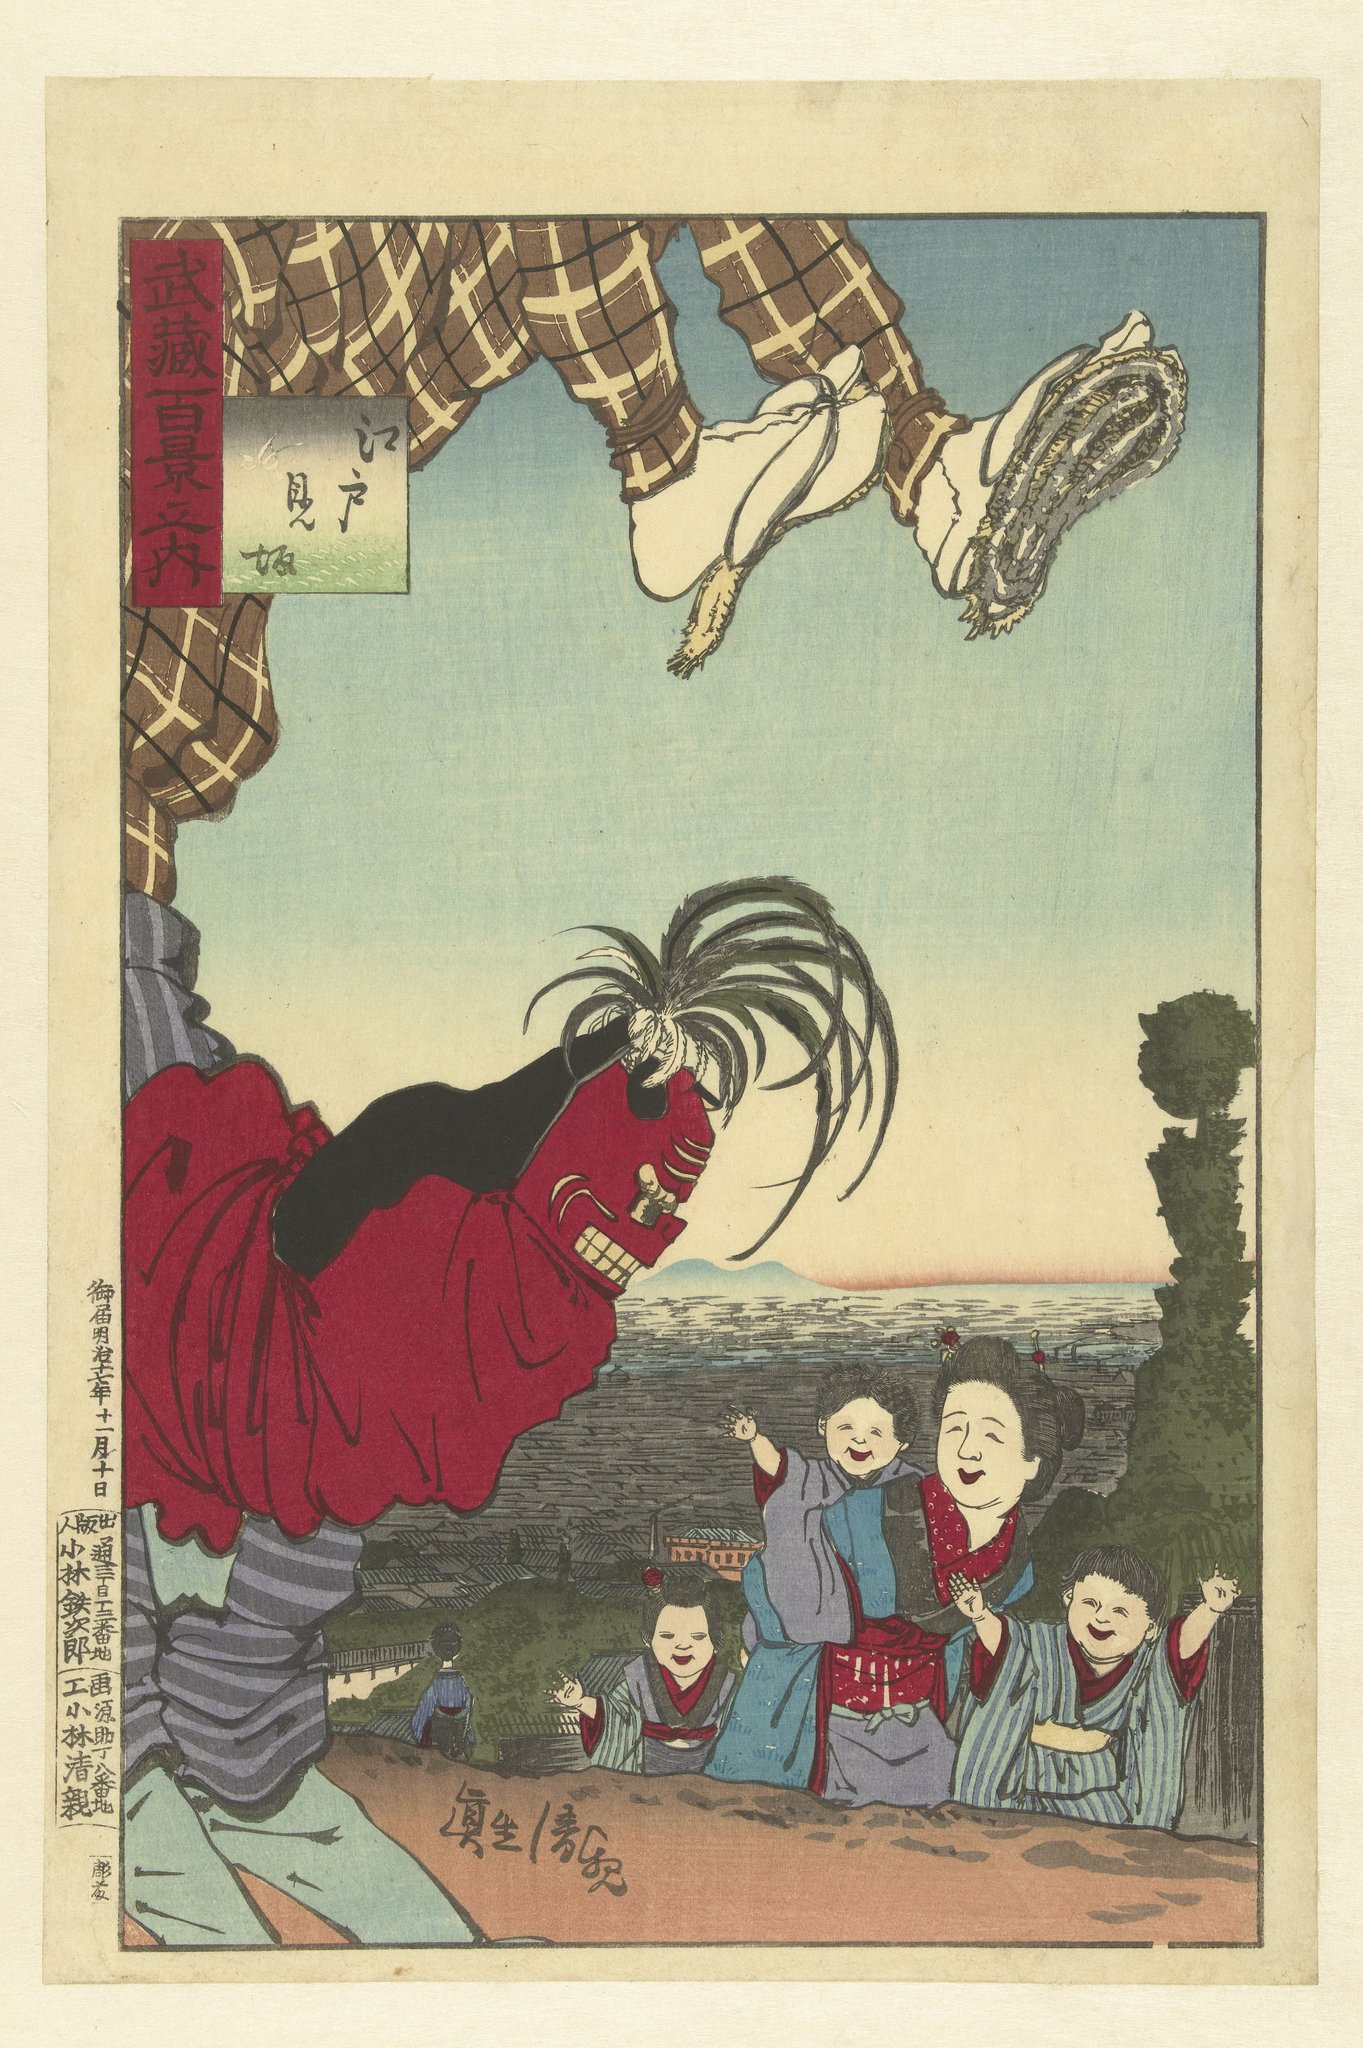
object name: print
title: Edo no kenba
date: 1884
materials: paper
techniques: woodcut, nishiki e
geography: tokyo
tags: acrobat ~ circus, mother and child(ren), woman and child(ren) (family group)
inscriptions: collector's mark: Lugt 2228, collector's mark: Lugt 2760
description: Moeder met drie kinderen kijkend naar een acrobaat, met rood masker waarop veren, staand op zijn handen; op de achtergrond uitzicht over de stad Tokyo.